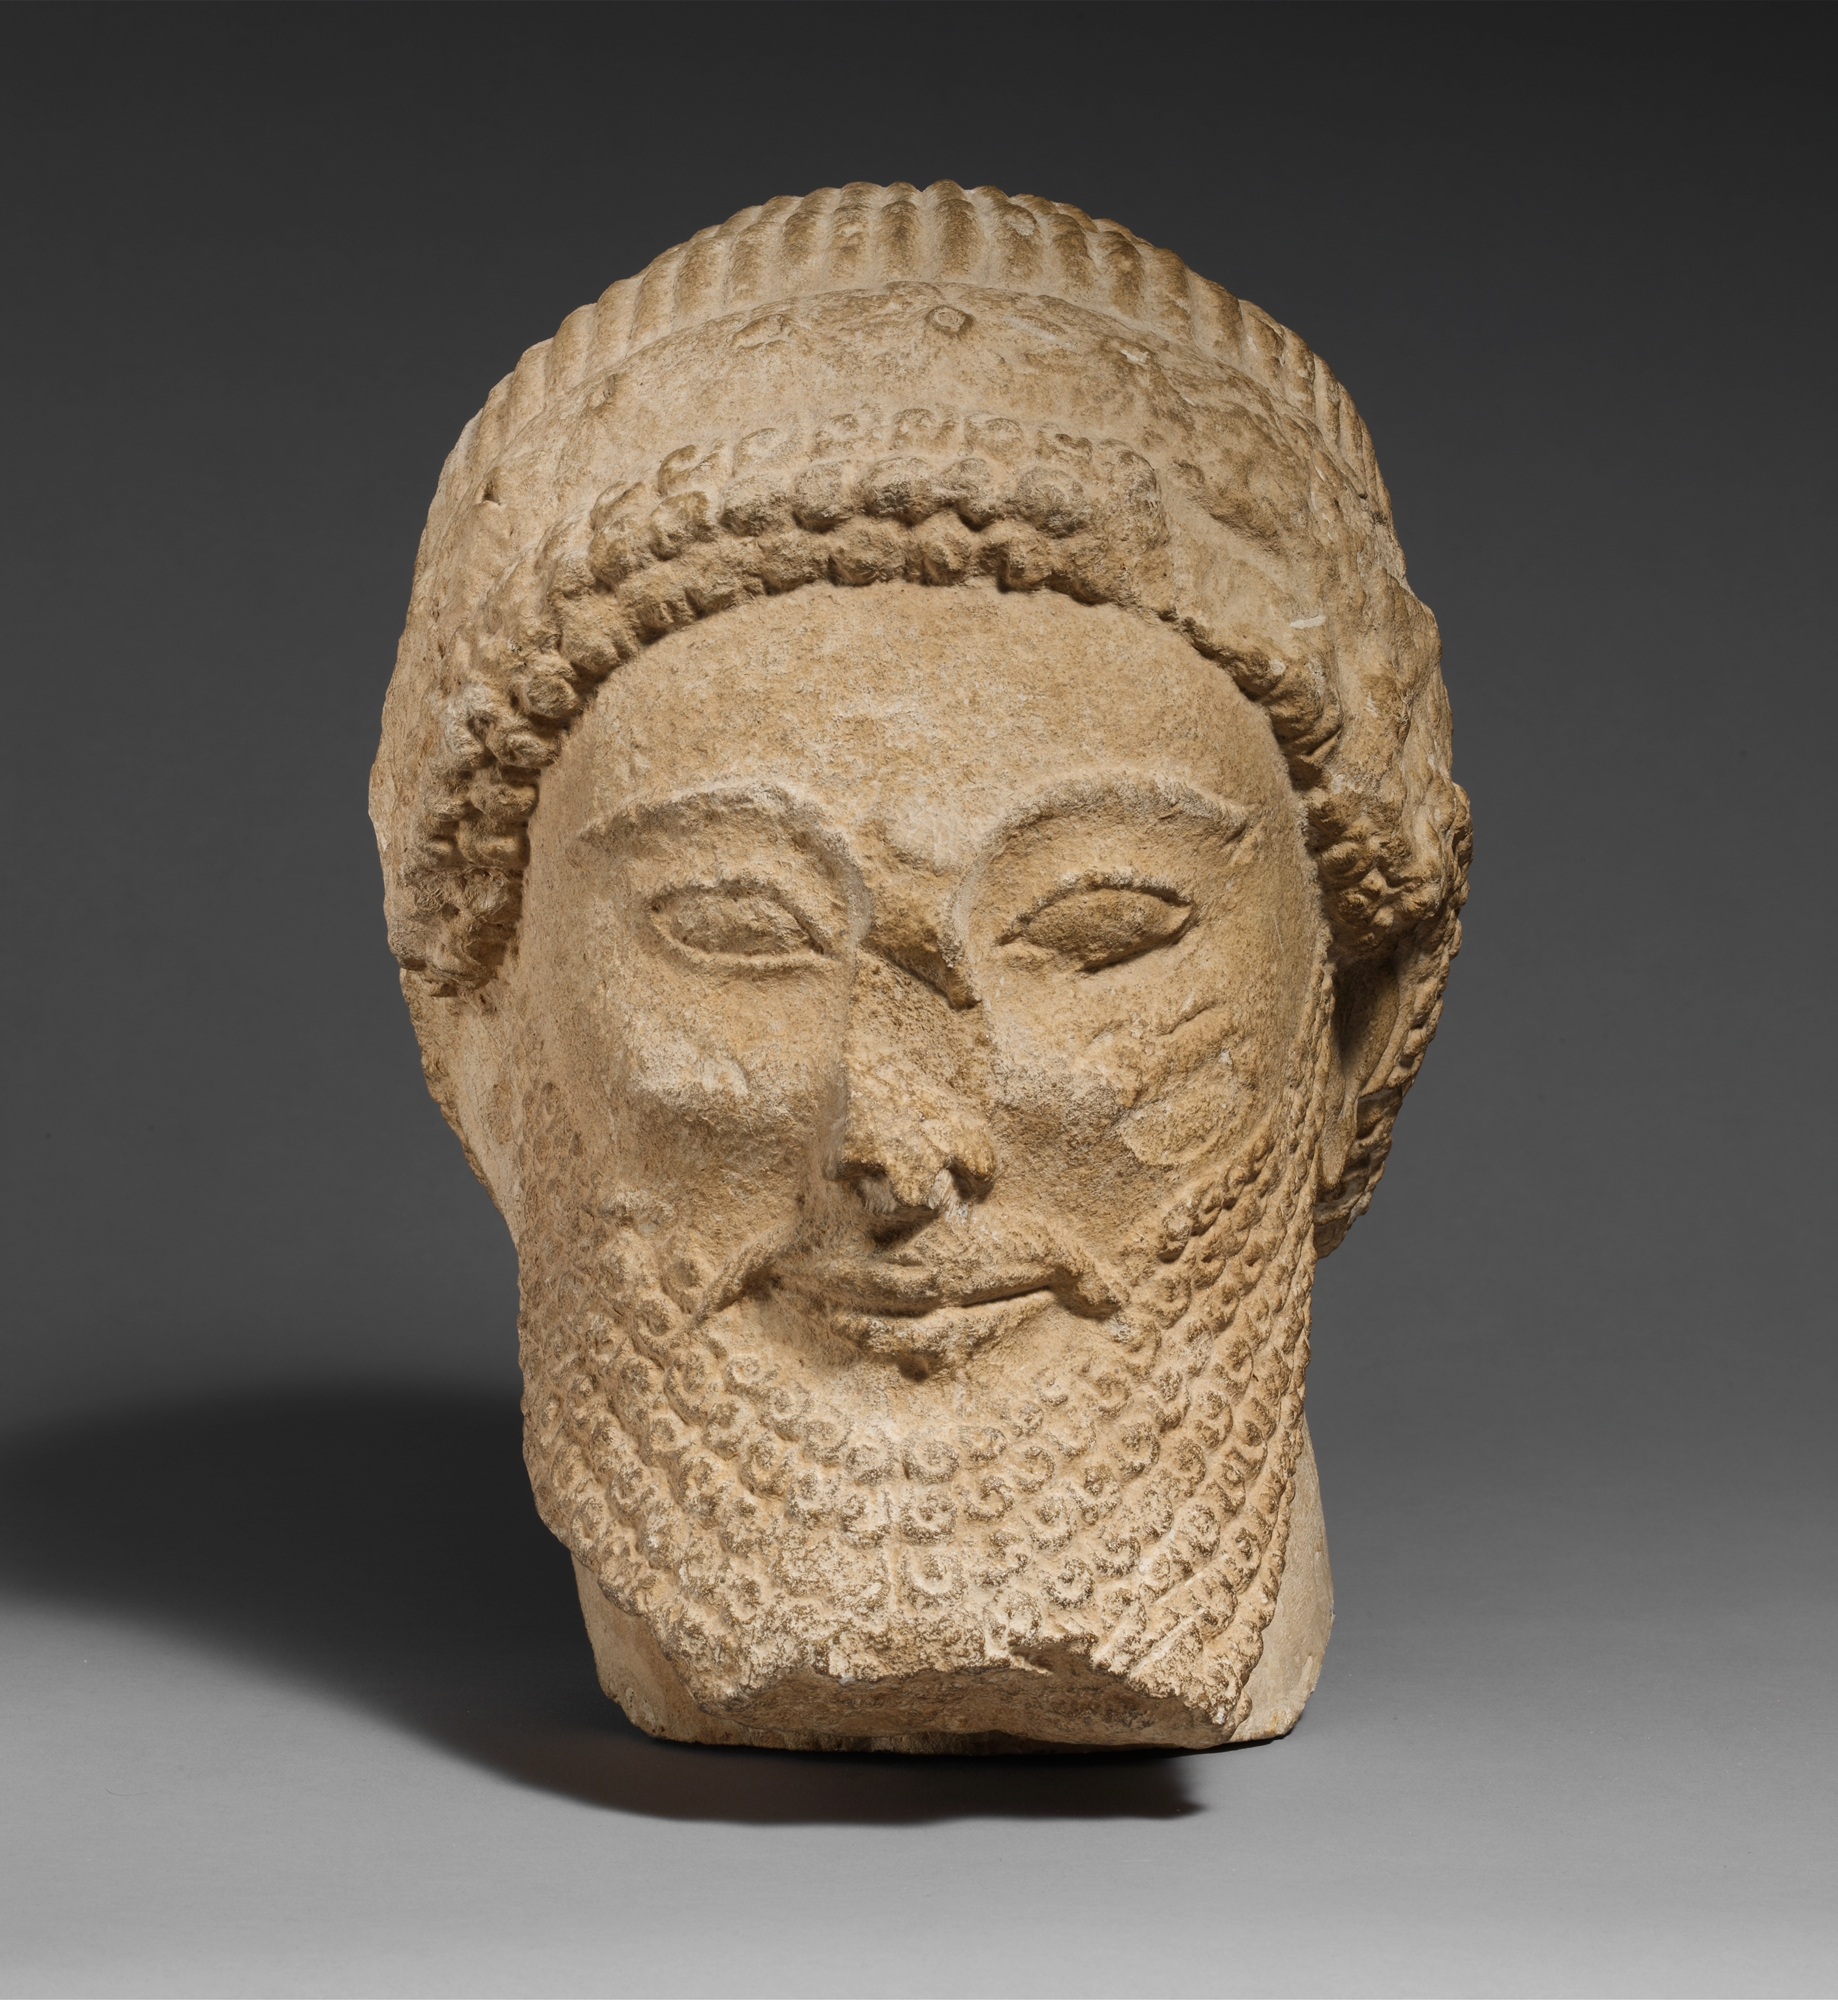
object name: head of a man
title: Limestone head of a bearded male with a wreath of flowers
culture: cypriot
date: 600-501 BCE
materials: limestone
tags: heads,men,flowers,wreaths